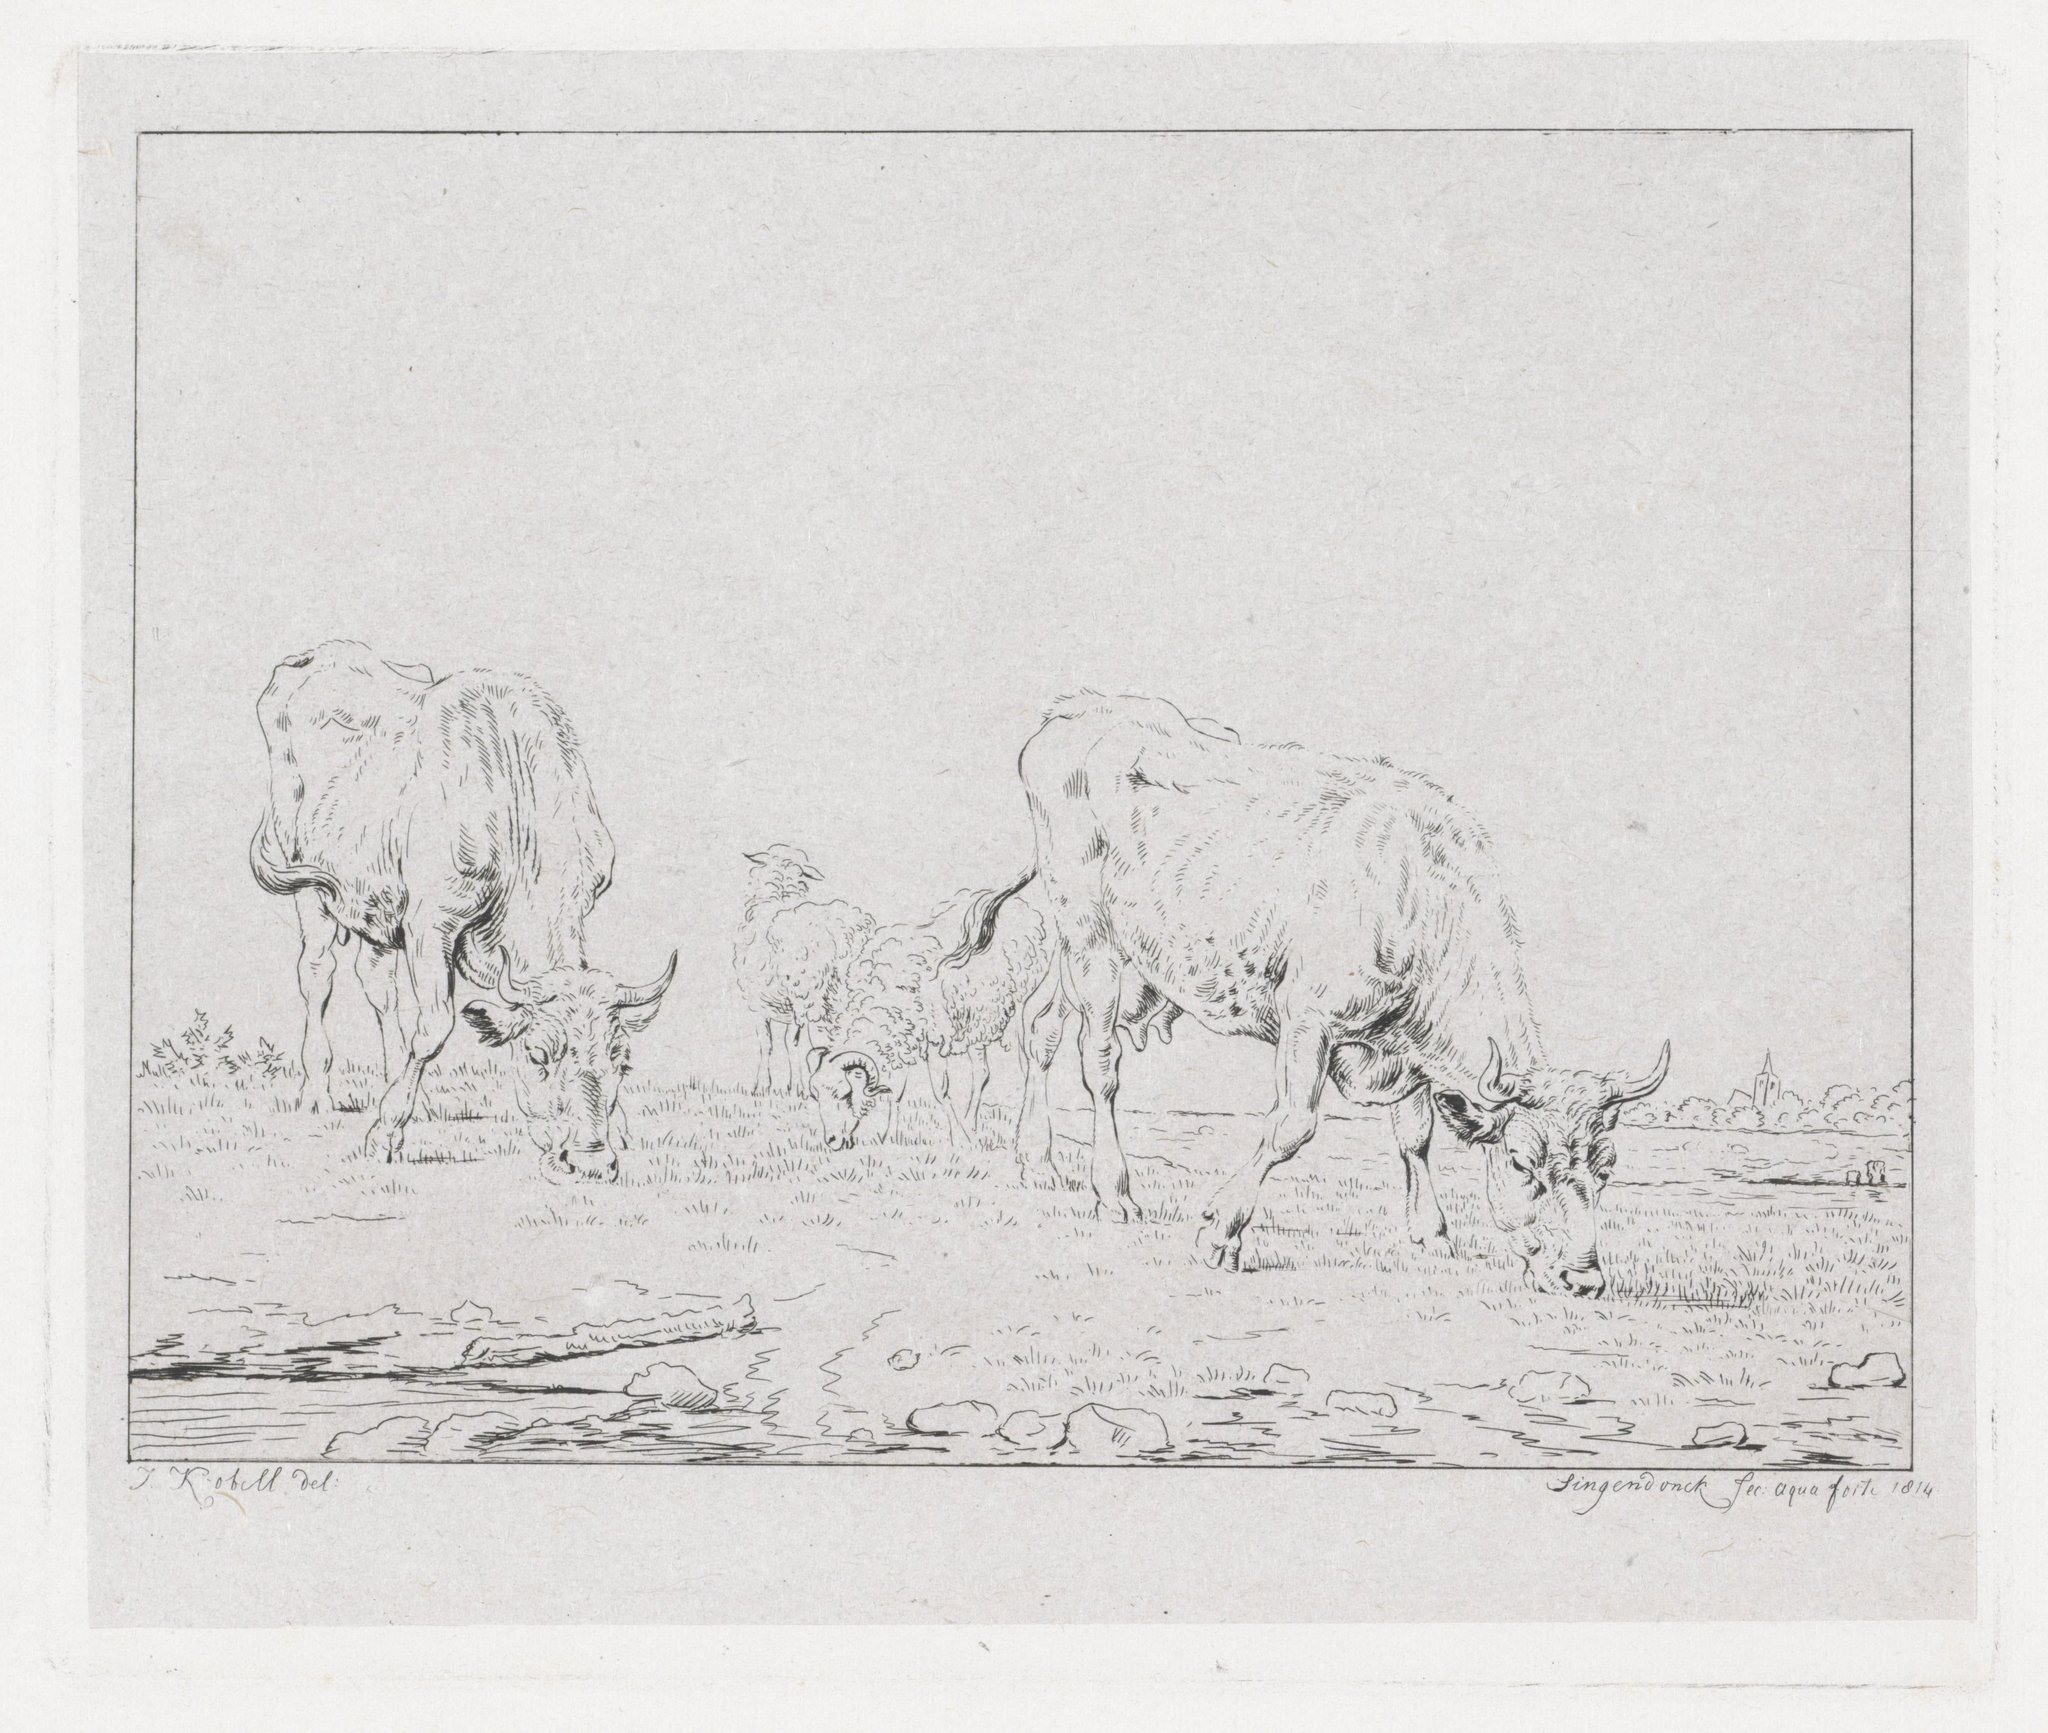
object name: print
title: Grazende koeien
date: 1814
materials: paper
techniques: etching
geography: utrecht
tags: cow, sheep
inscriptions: collector's mark: Lugt 2228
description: Twee grazende koeien in een weidelandschap. Daartussen een ram en een ooi.